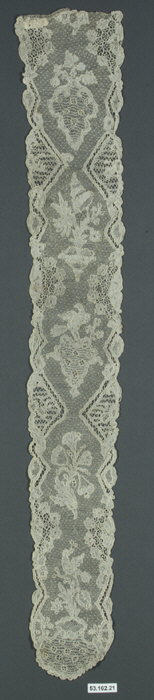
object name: lappet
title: Lappets (one of a pair)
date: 1701-1800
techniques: lace